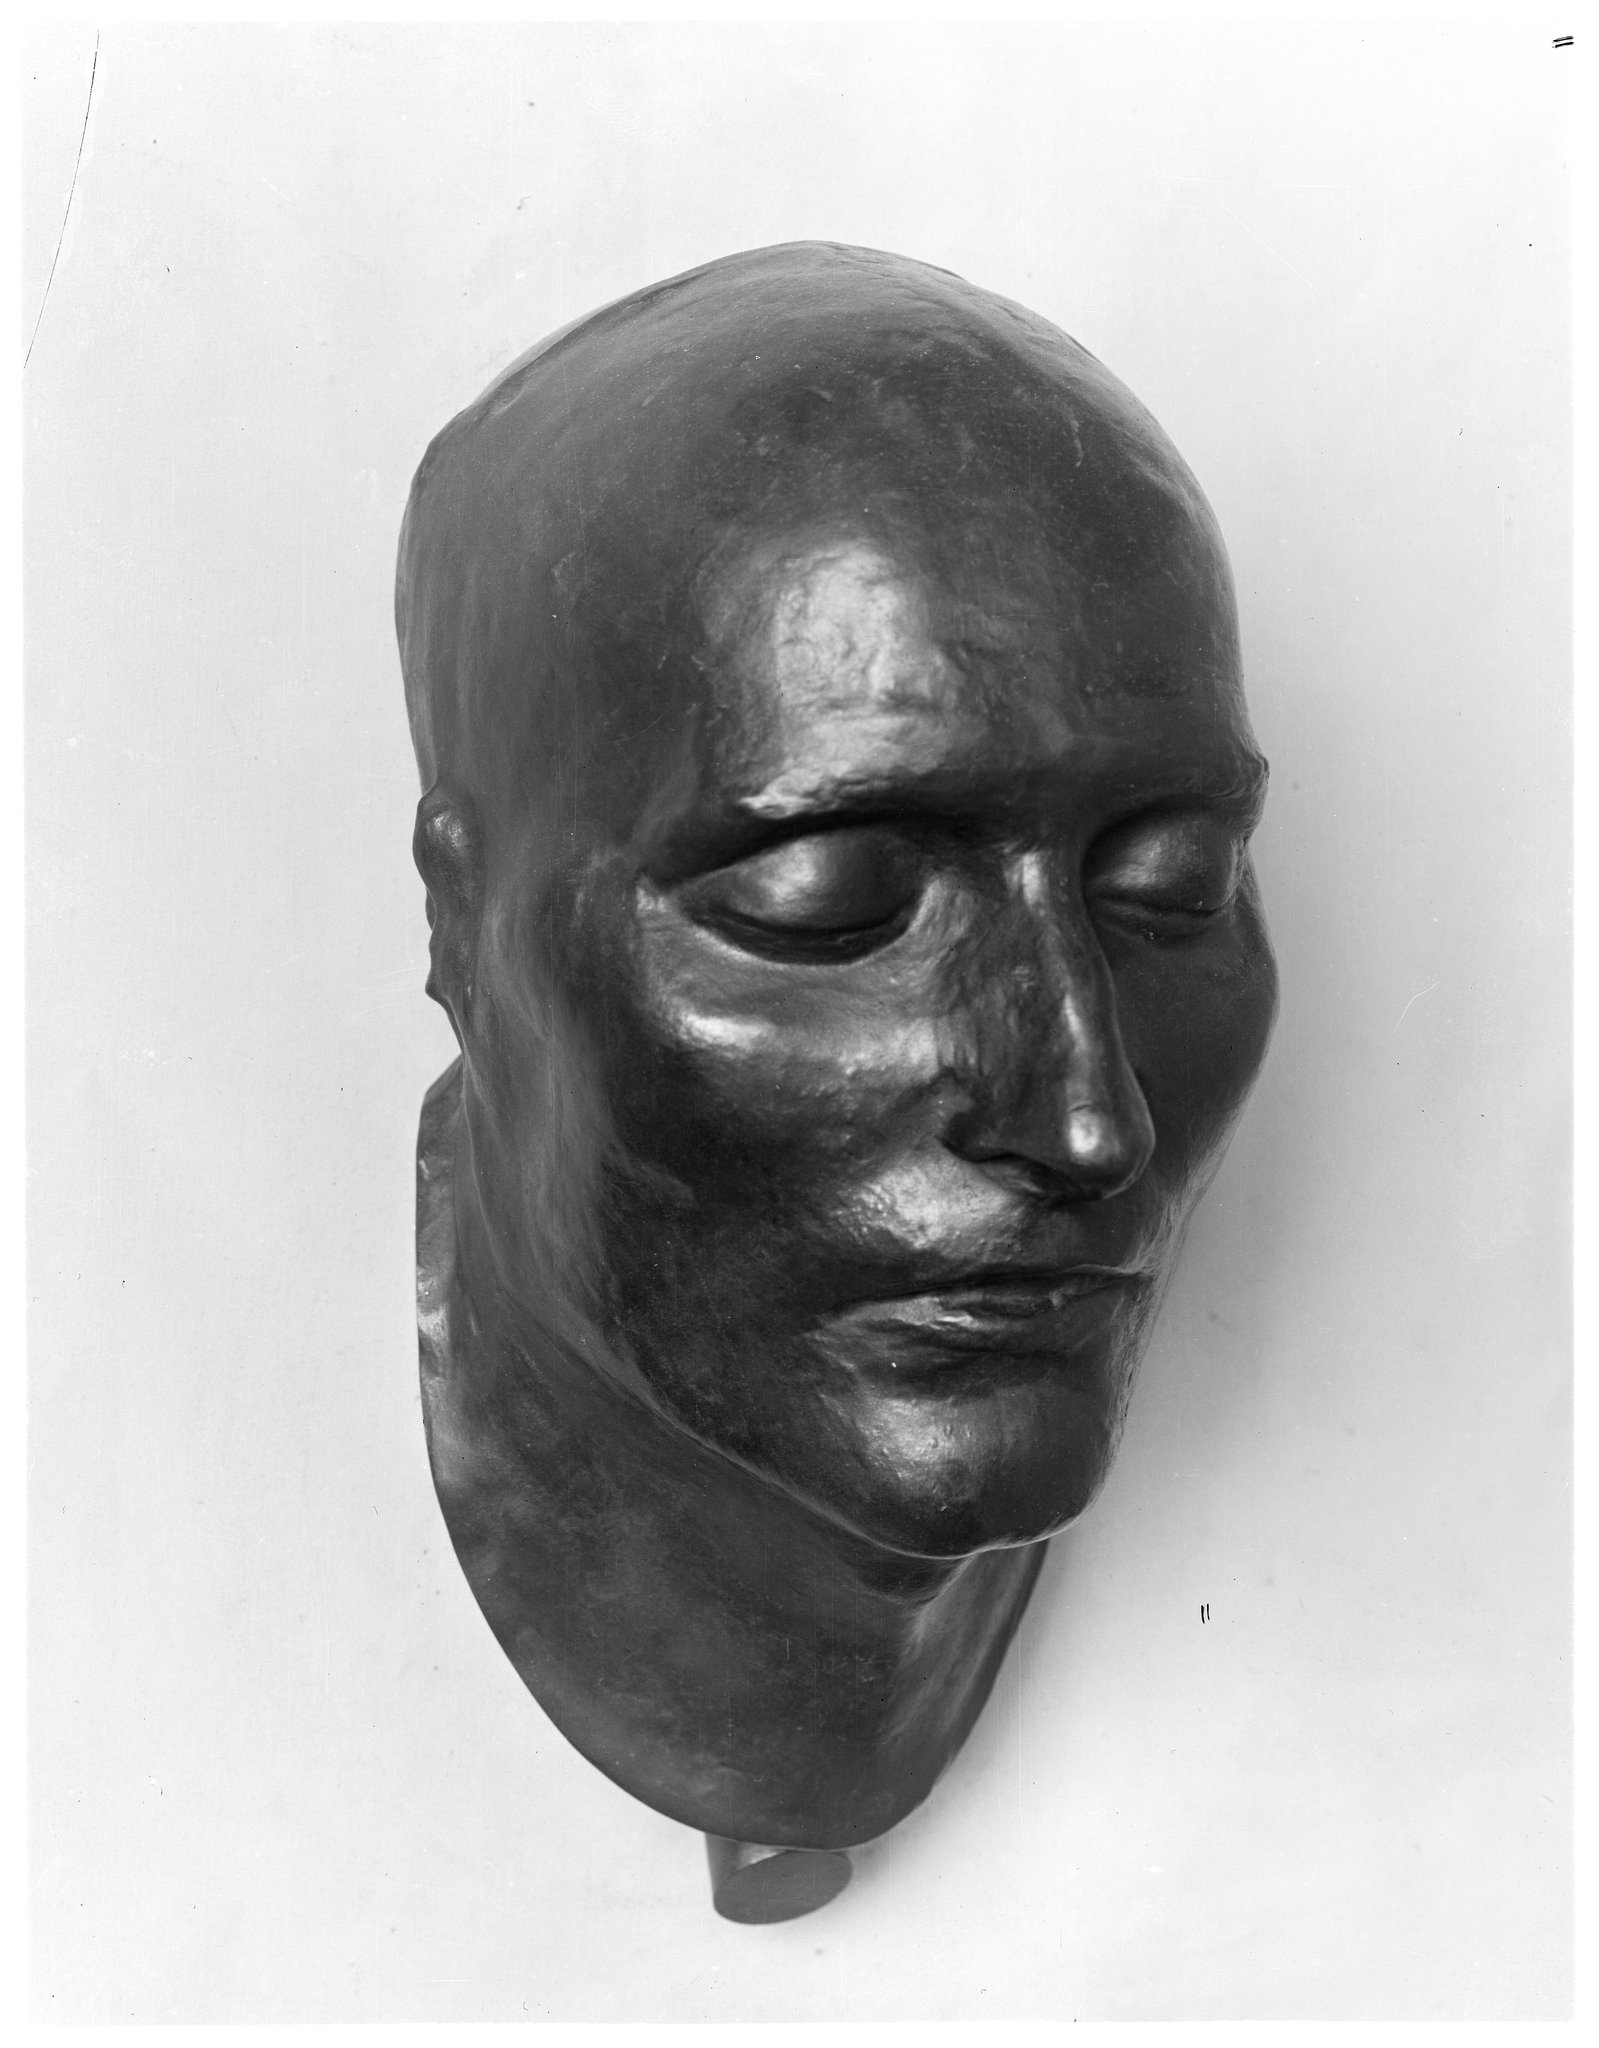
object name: death mask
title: Death mask of Napoleon I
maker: francesco antommarchi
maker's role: artist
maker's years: 1780-1838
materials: bronze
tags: masks,napoleon i